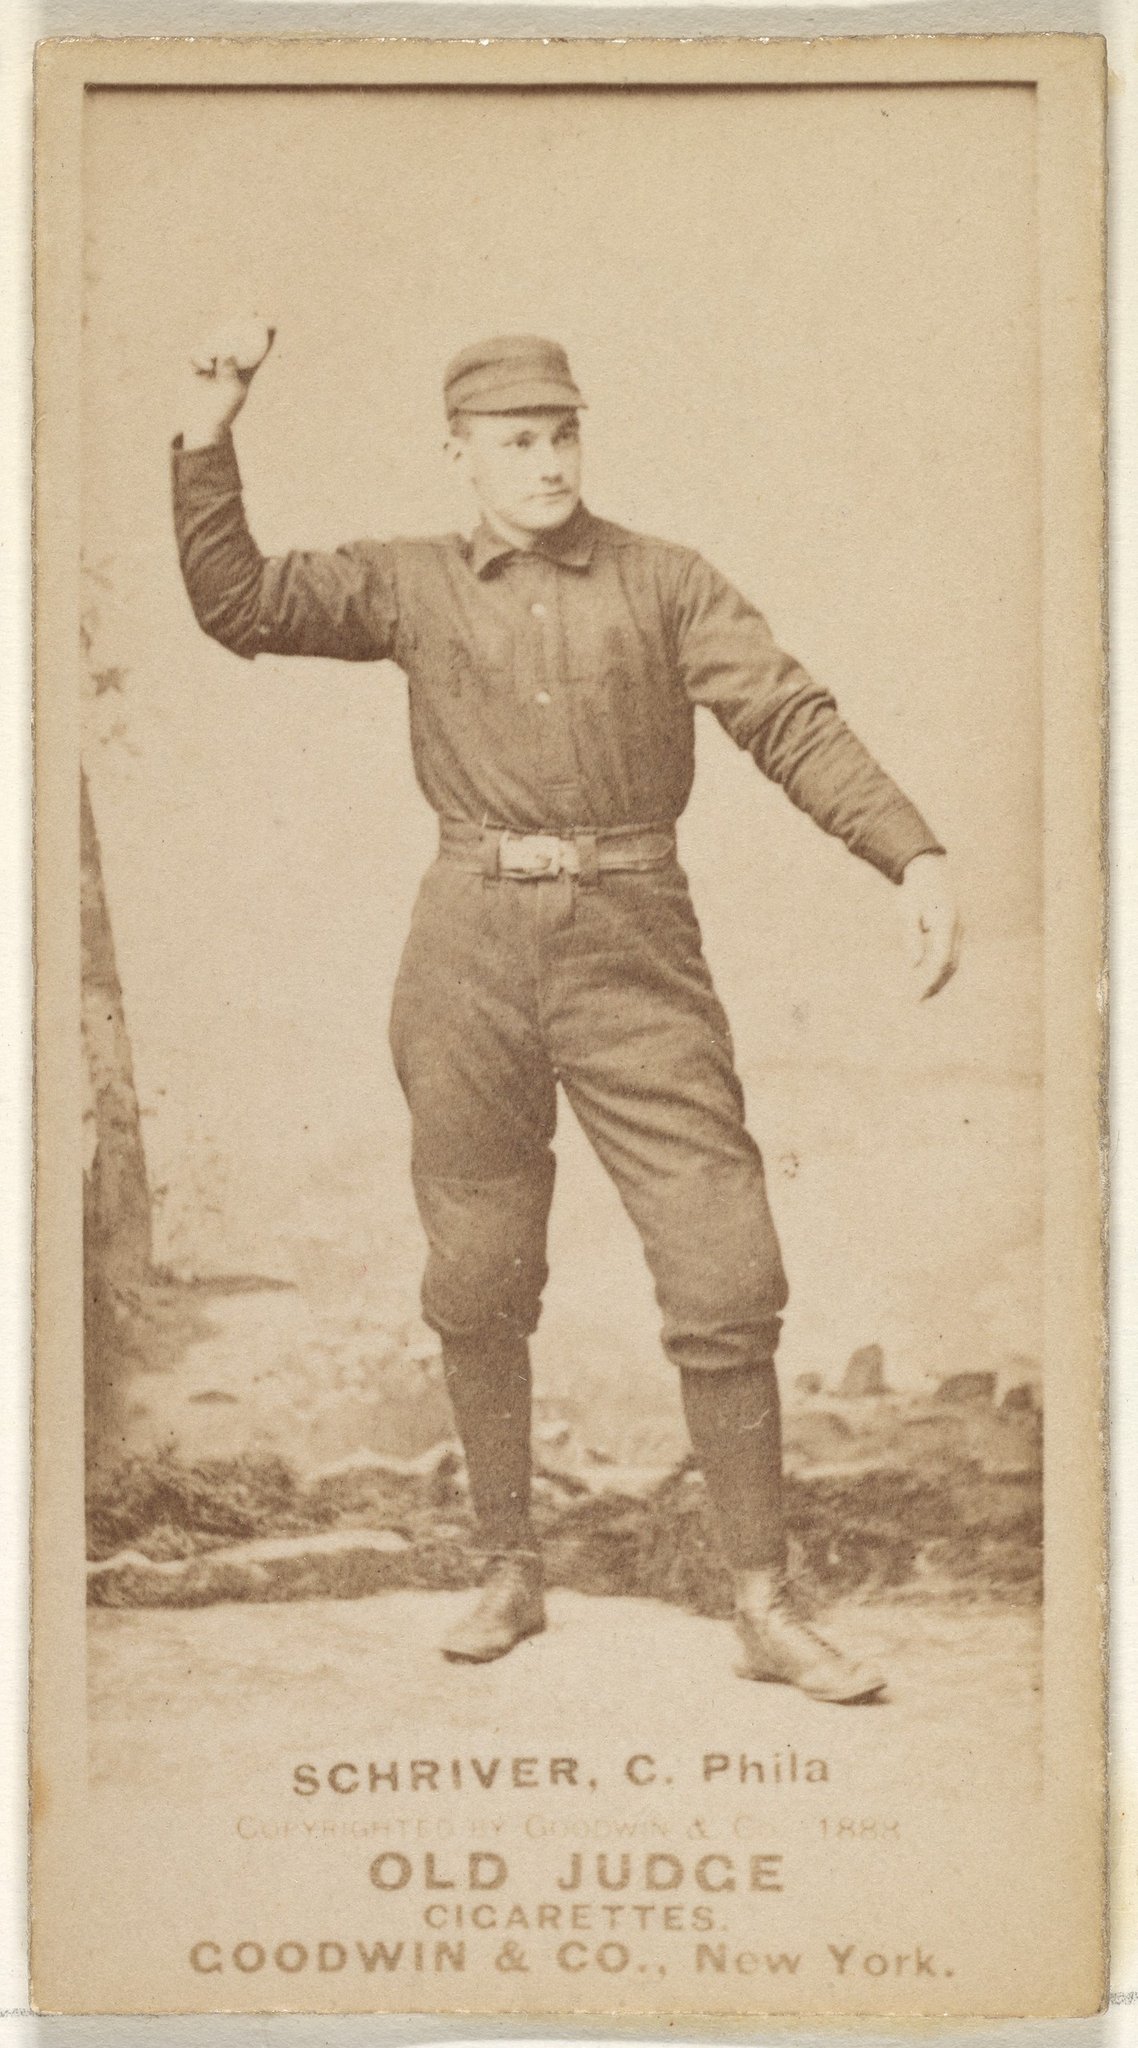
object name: baseball card, photograph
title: William Frederick "Pop" Schriver, Catcher, Philadelphia, from the Old Judge series (N172) for Old Judge Cigarettes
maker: goodwin & company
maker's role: publisher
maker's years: 1850-1950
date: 1888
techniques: albumen silver print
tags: men,portraits,baseball,athletes